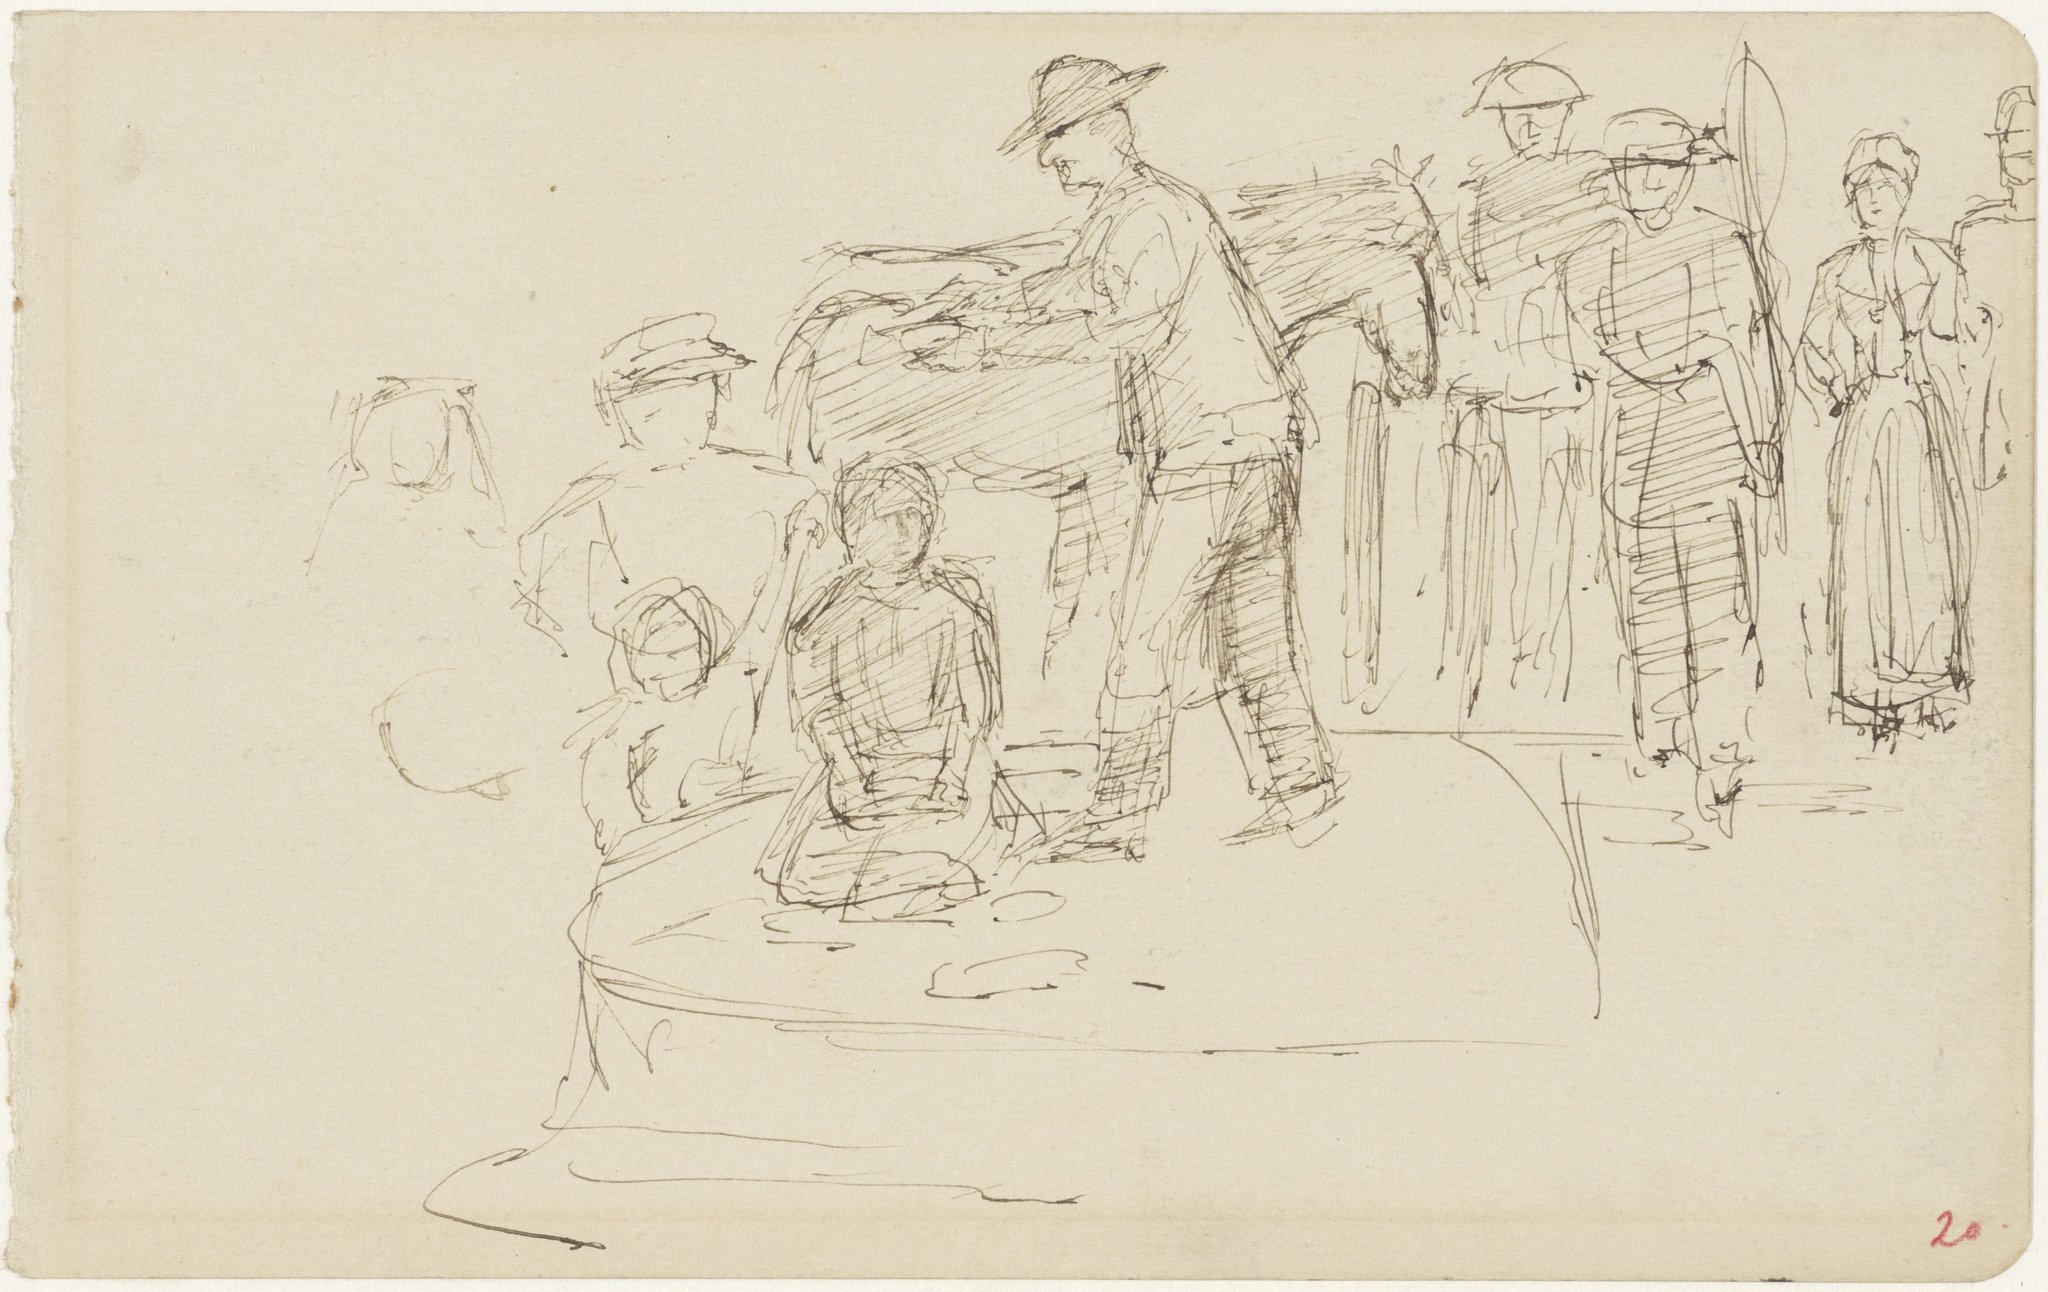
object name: drawing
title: Paardenmarkt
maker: jozef israëls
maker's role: draughtsman, painter, print maker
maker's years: 1824-1911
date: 1834-1911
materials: ink, paper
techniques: pen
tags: horse, market